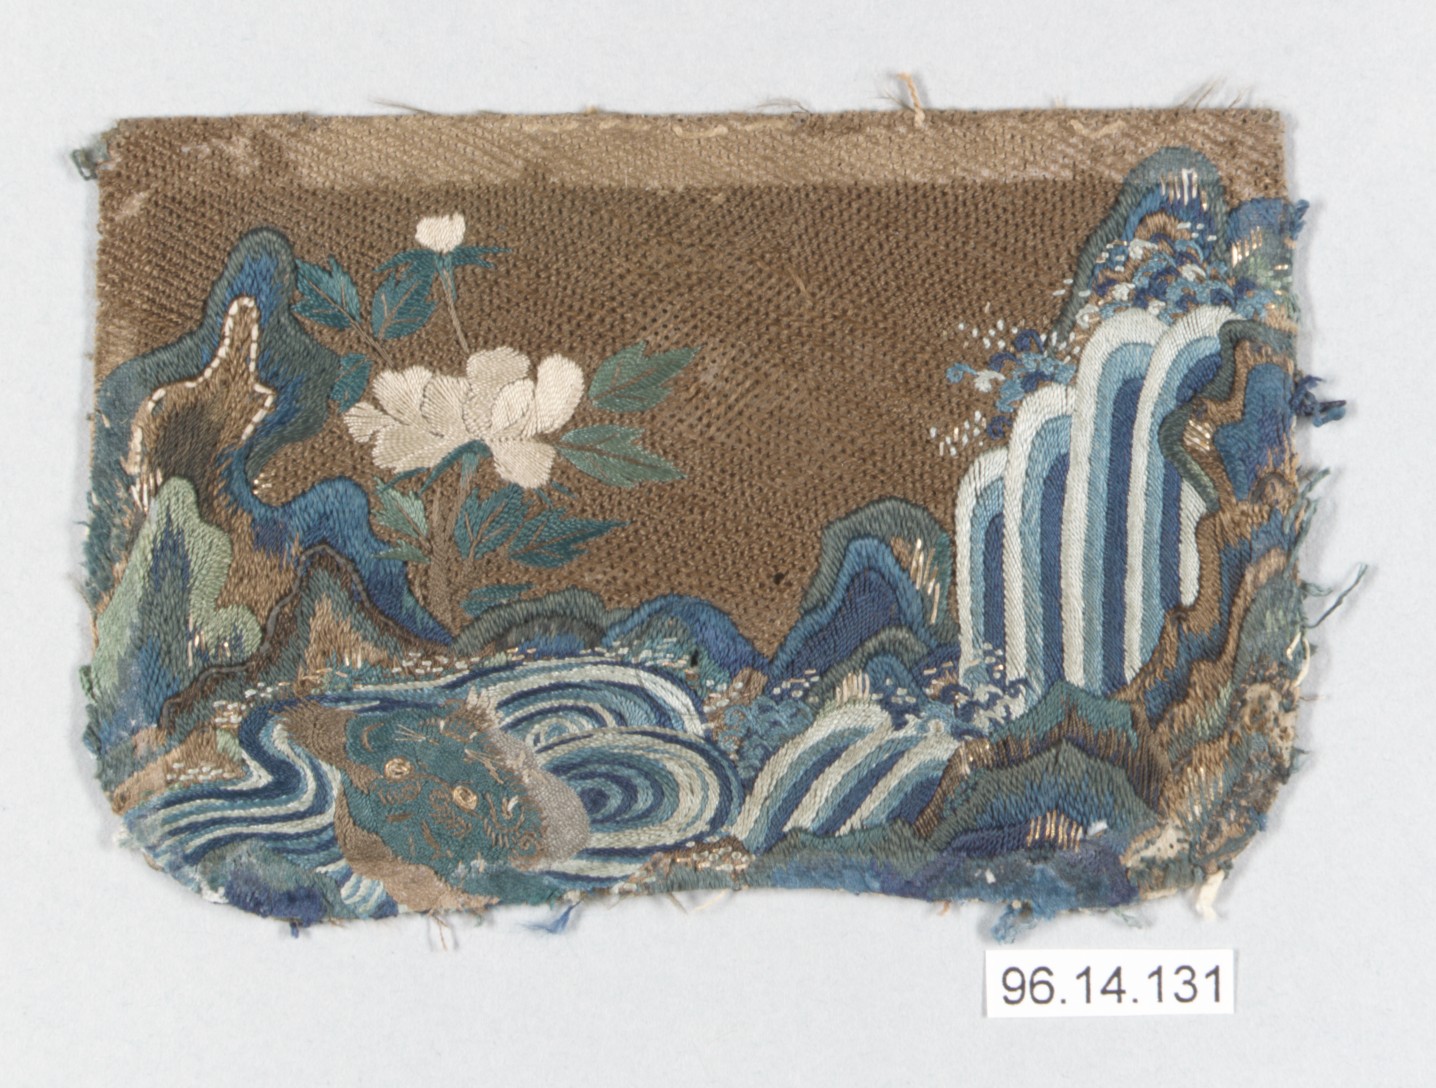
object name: piece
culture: japanese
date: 1701-1800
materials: metal thread, paper, silk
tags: waterfalls,flowers